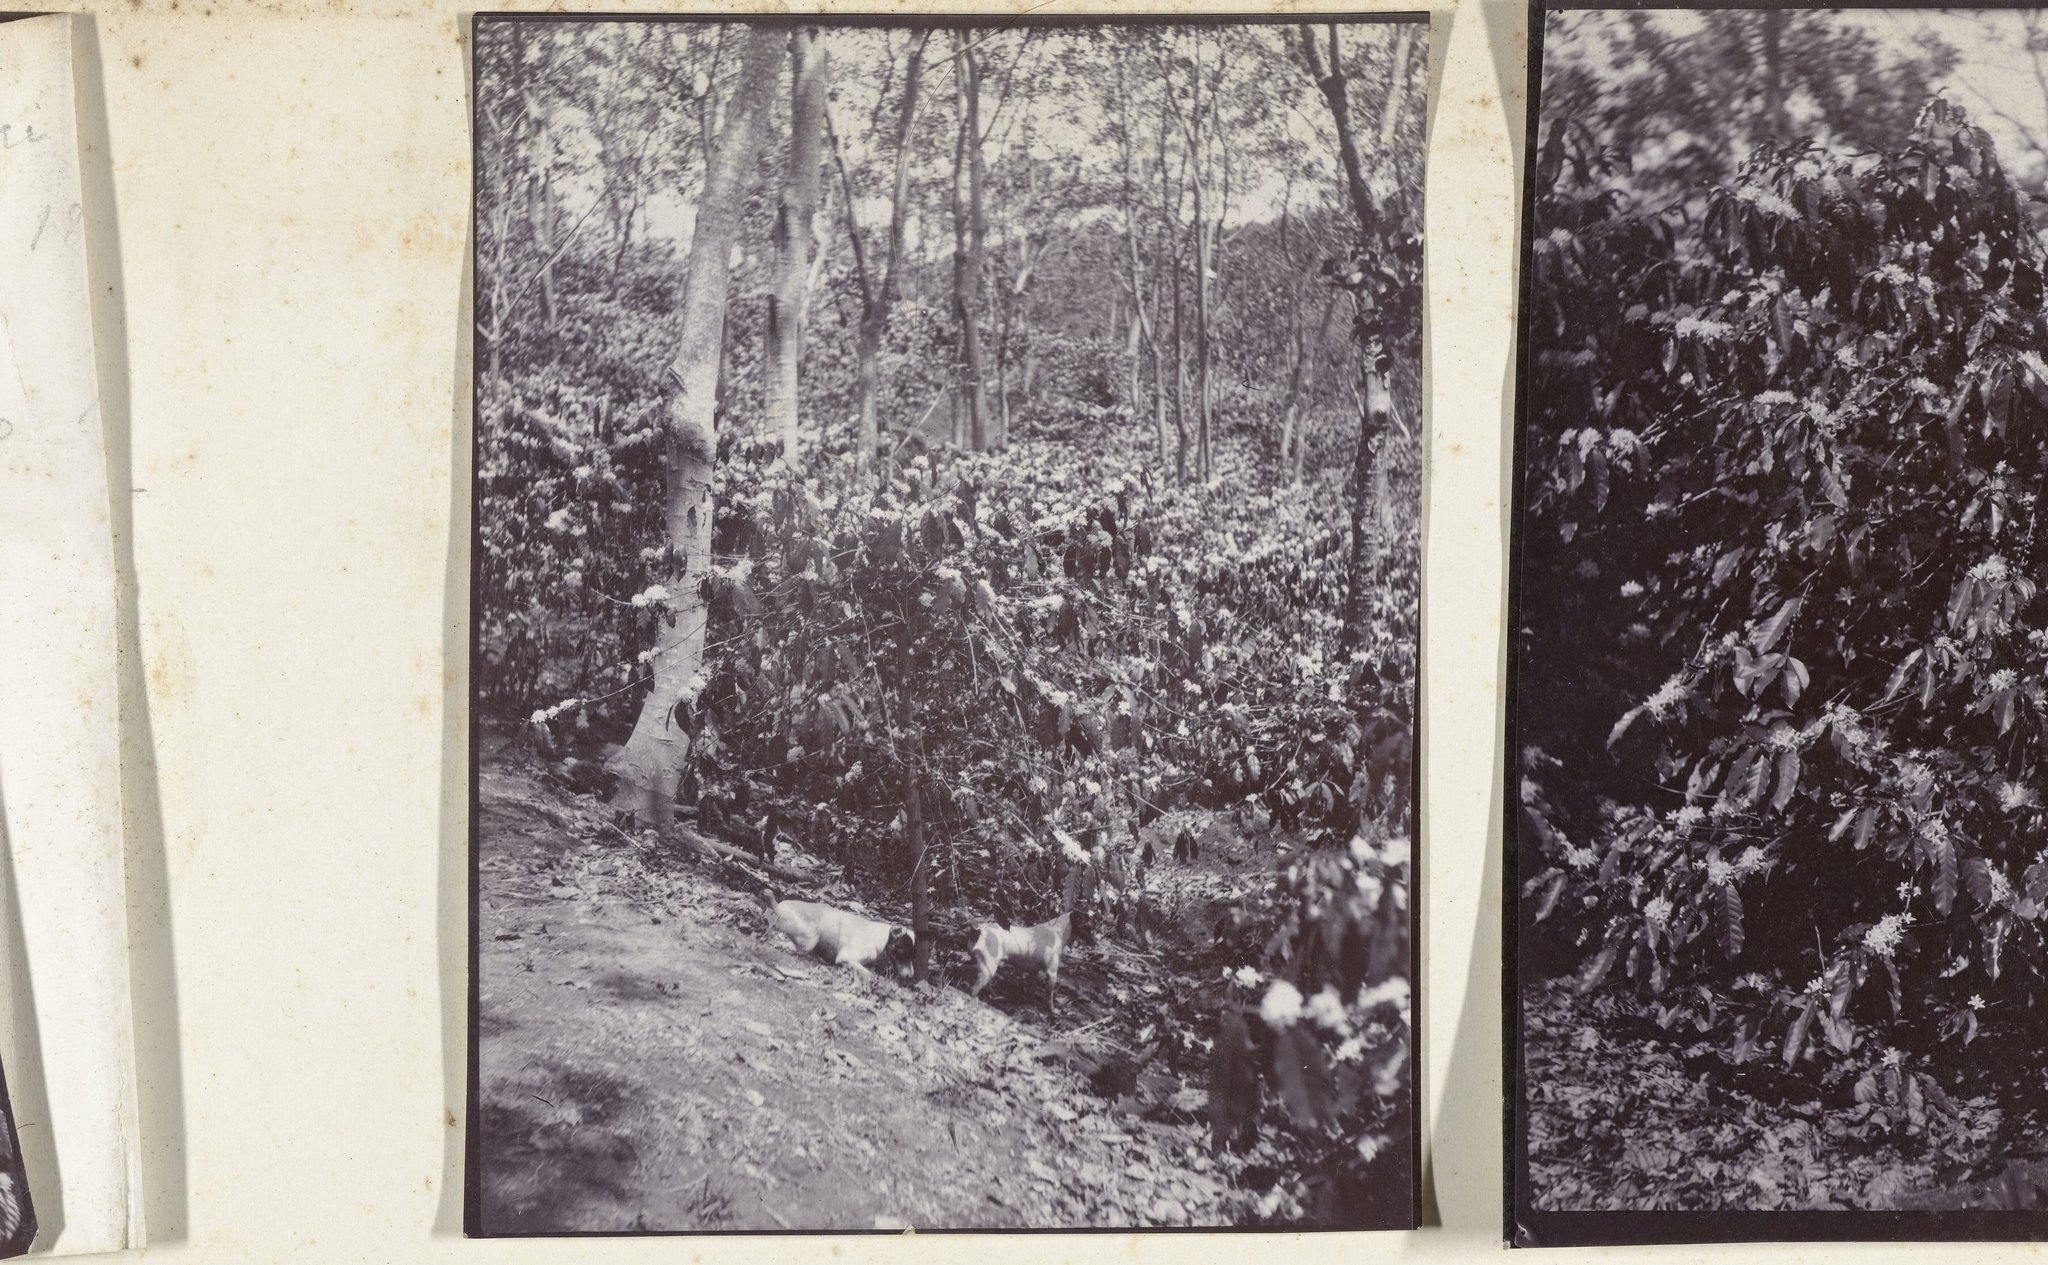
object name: photograph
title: Bloei van een koffiestruik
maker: Anonymous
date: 1890-1910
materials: cardboard, paper, photographic support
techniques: gelatin silver print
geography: indonesia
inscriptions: caption: ‘Koffietuinen van Silo Sanen’